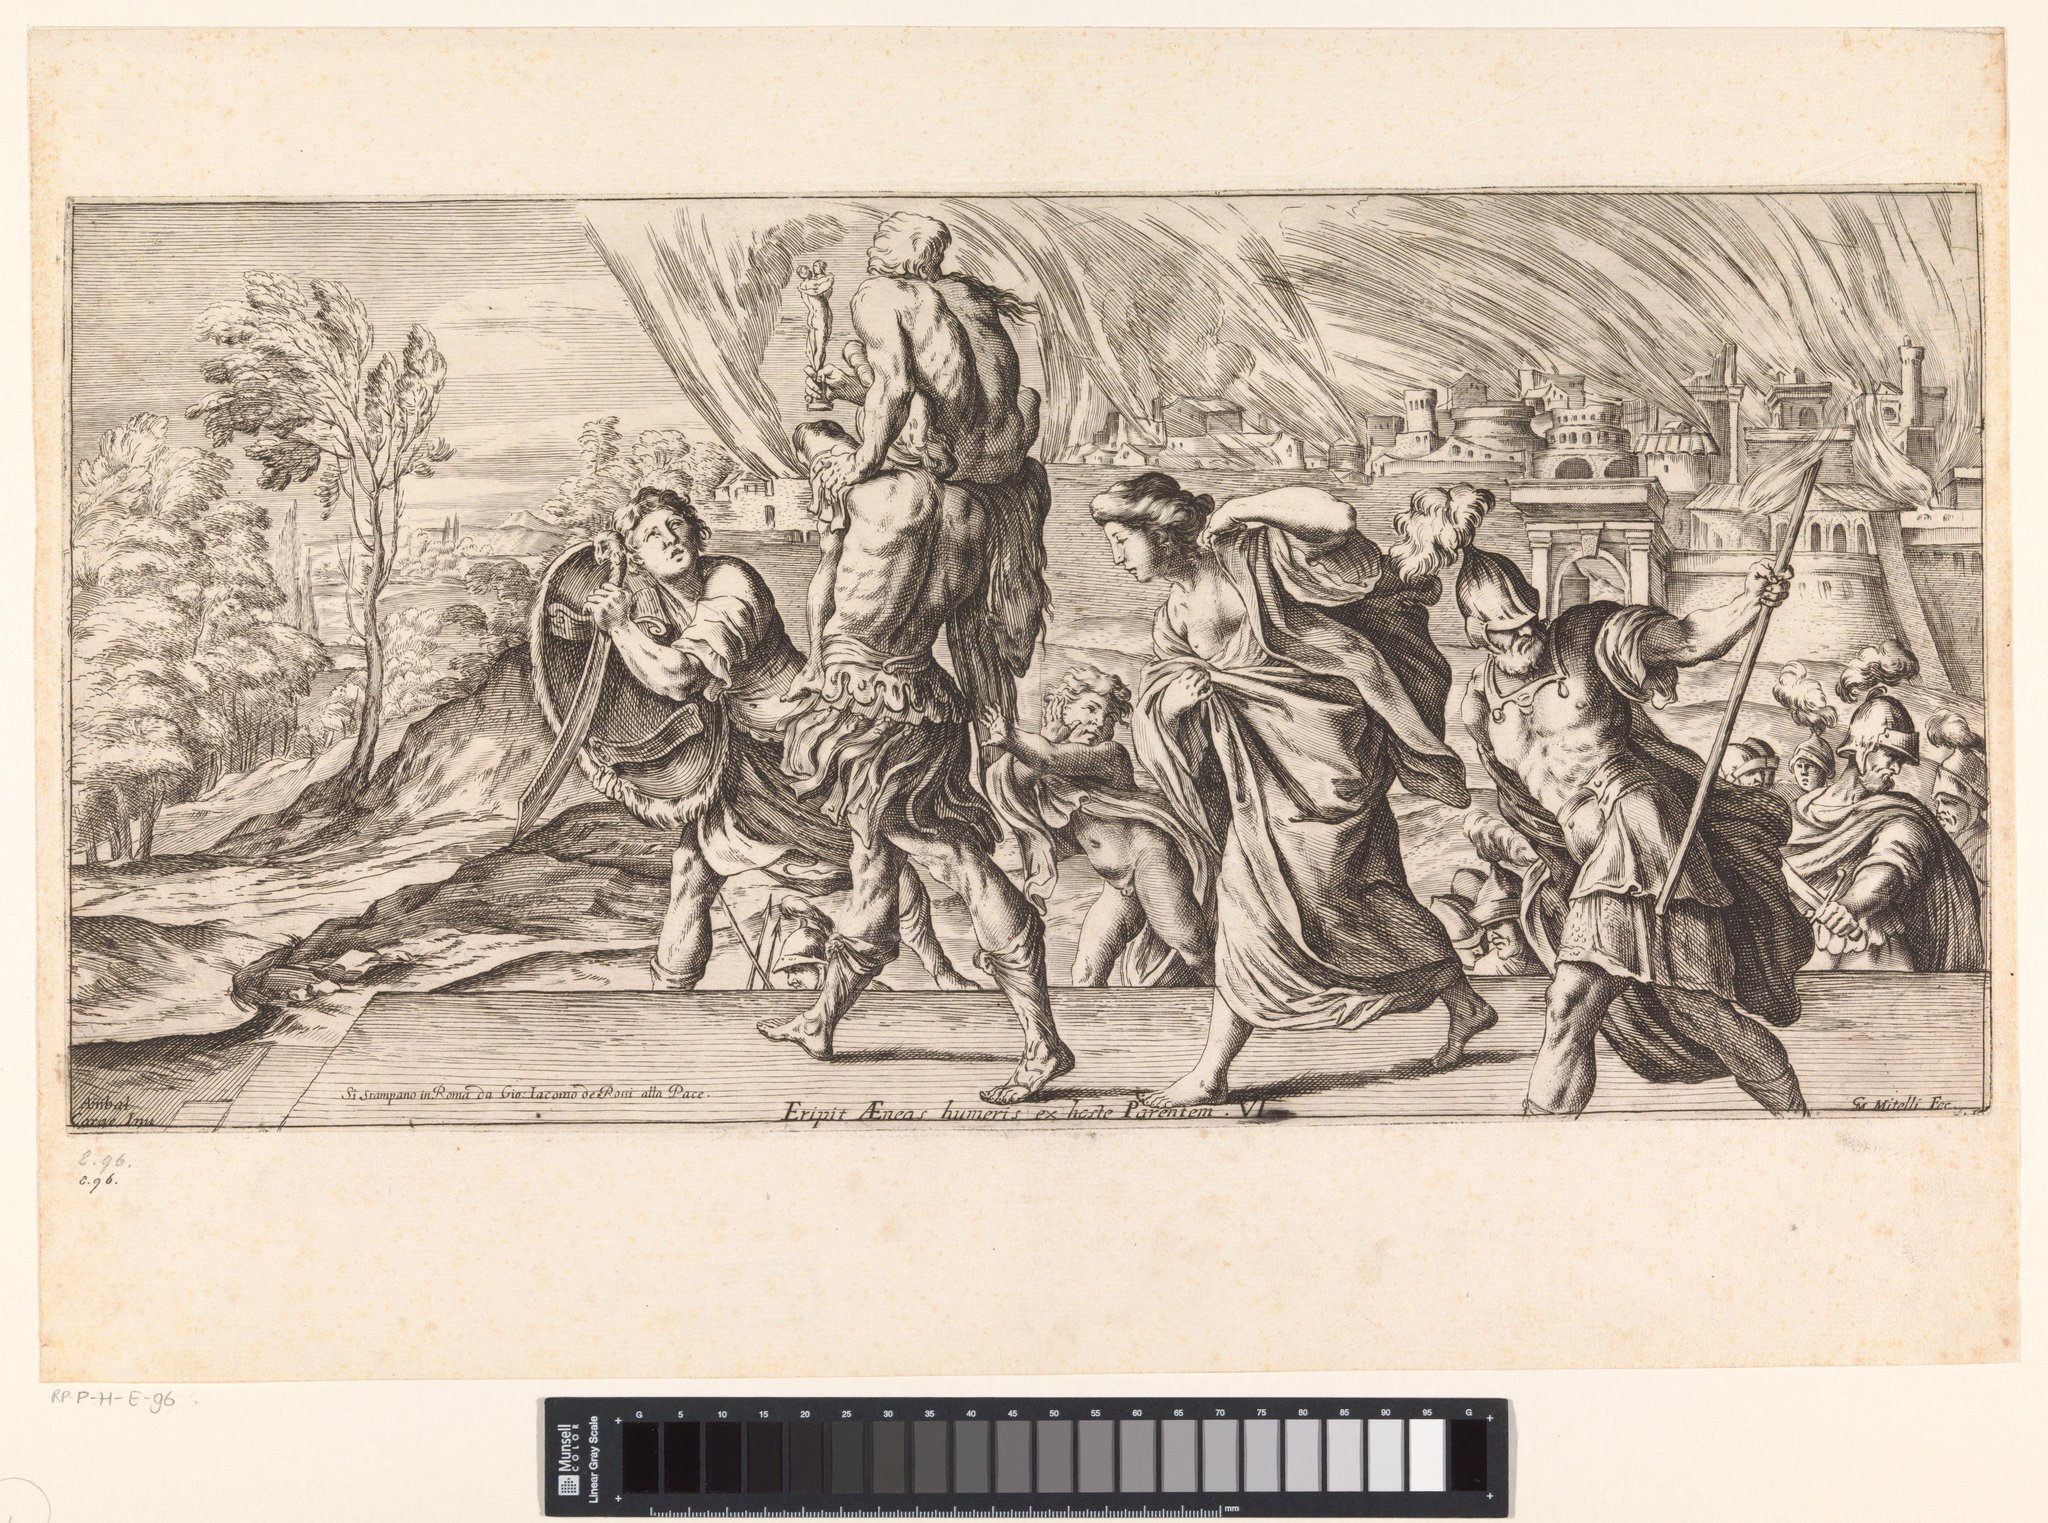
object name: print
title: Omzwervingen van Aeneas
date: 1663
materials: paper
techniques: etching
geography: italy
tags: 'pius aeneas': aeneas, leading ascanius, escapes from burning troy, carrying his father anchises with the penates; his wife creusa, who sets out with them, is lost on the way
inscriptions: collector's mark: Lugt 11, collector's mark: ‘Hinloopen’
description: Deze prent maakt deel uit van een reeks van 20 prenten (+ titelprent) naar de fresco's door de Carracci's in Palazzo Fava Ghisilieri te Bologna. Deze prent maakte oorspronkelijk deel uit van liber nr. 22 van de Atlas van Rome, uit de collectie Hinloopen. In dit album waren een aantal prentreeksen naar bekende zeventiende eeuwse frescoseries bijeengebonden. In 1709 heeft Schijnvoet op last van de burgemeesters van Amsterdam de collectie herordend. De prenten uit liber 22 kwamen terrecht in Schijnvoet boek nr. 10. De laatst gedateerde reeks in het album is gedateerd 1691. Het album moet dus na deze datum gebonden zijn. De band is in de Rijksakademietijd uit elkaar gehaald. De marges van de prenten zijn bij het opbergen in het Rijksprentenkabinet vaak drastisch afgesneden. Van een aantal series waren de prenten teruggeslagen om in het album te passen. (Zie: Waals, Jan van der. De prentschat van Michiel Hinloopen. 's-Gravenhage: SDU uitgeverij, 1988, pp. 173-174.)